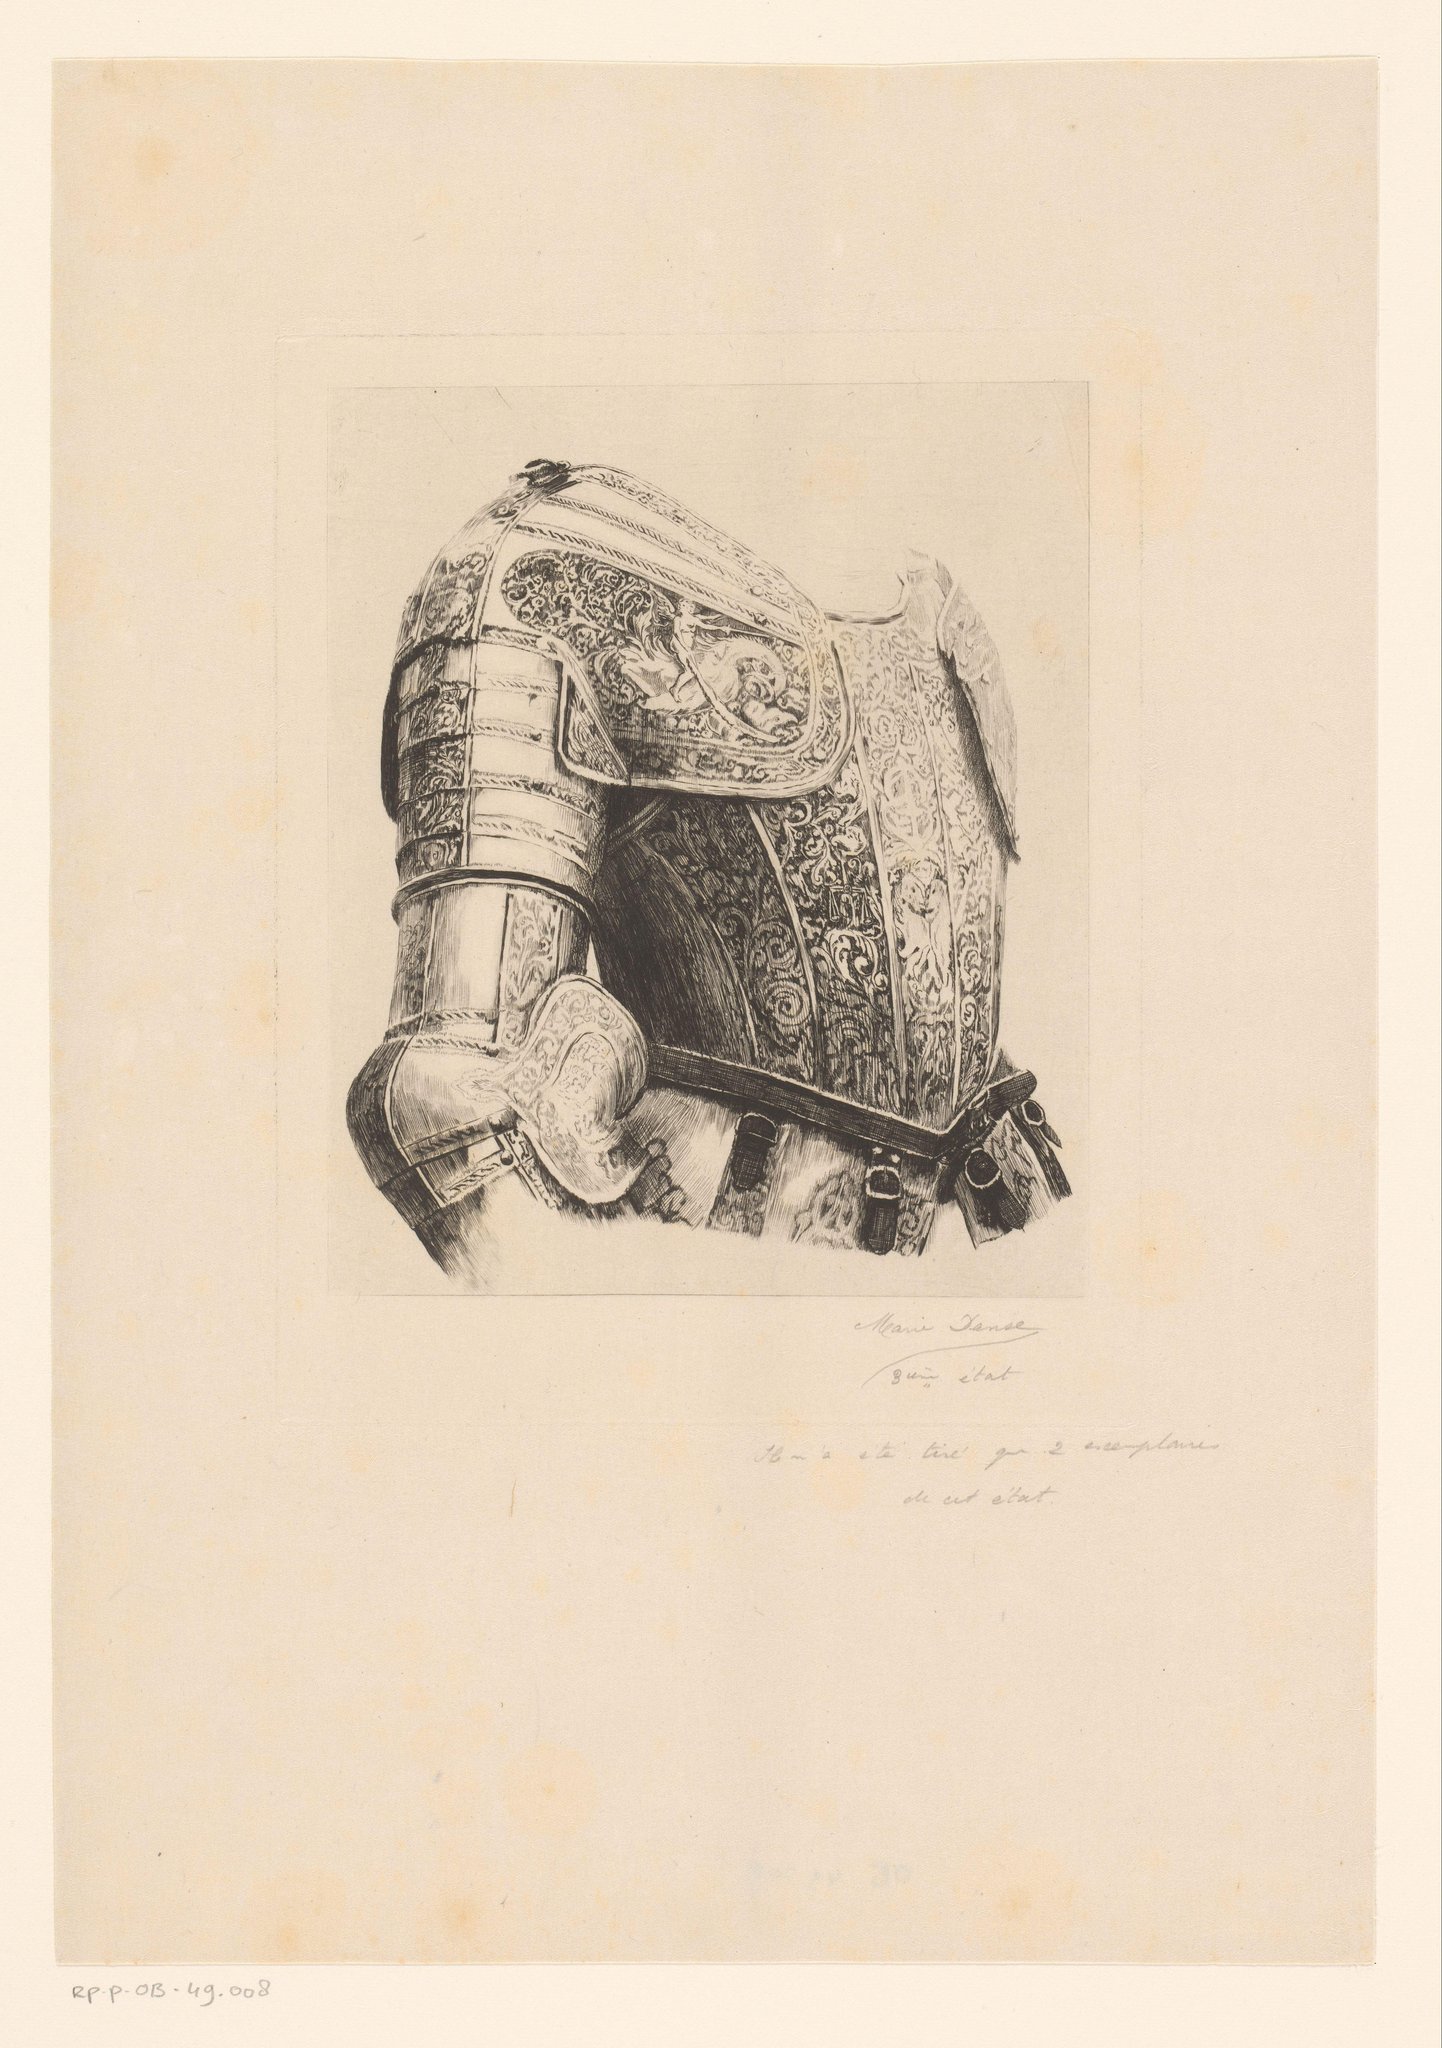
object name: print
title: Zestiende-eeuws, gegraveerd harnas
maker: marie danse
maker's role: print maker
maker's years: 1867-1942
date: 1887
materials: paper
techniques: etching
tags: cuirass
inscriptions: inscription: ‘3 em état; Il n à été tire que 2 exemplaire de ut état’